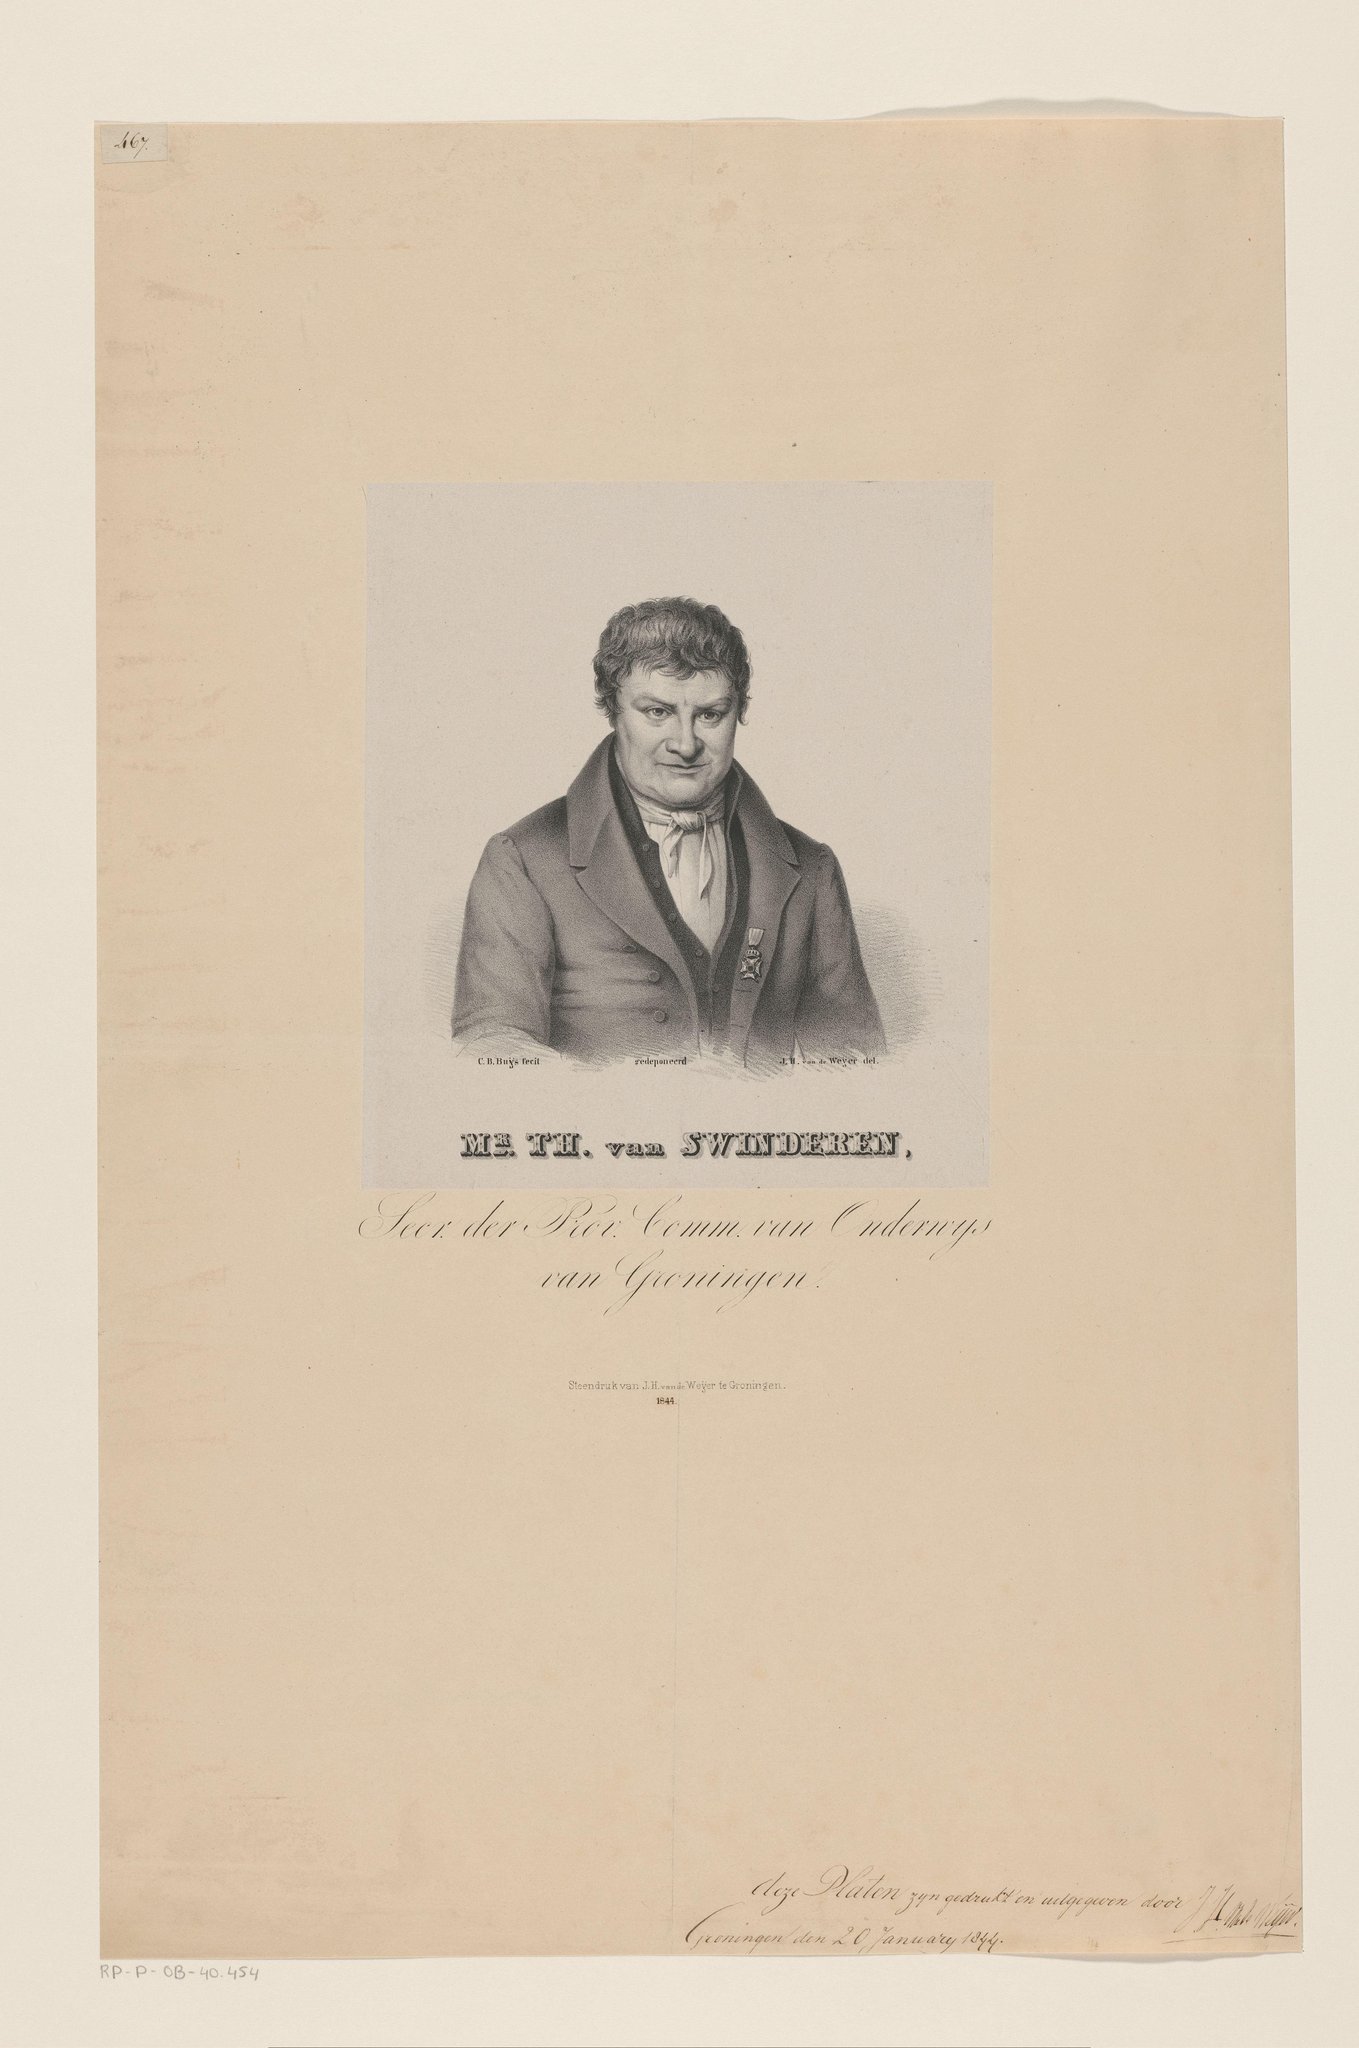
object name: print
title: Portret van Theodorus van Swinderen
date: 1844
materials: paper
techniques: lithograph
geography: groningen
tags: theodorus van swinderen, historical persons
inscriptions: collector's mark: Lugt 2228, inscription: ‘Deze Platen zijn gedrukt en uitgegeven door J.H. van de Weijer / Groningen den 20 January 1844’